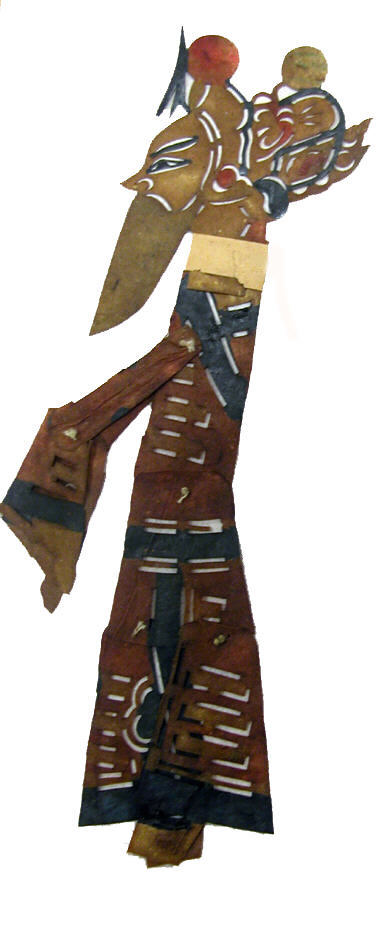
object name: shadow player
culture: chinese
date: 1801-1900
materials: cord, skin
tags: men